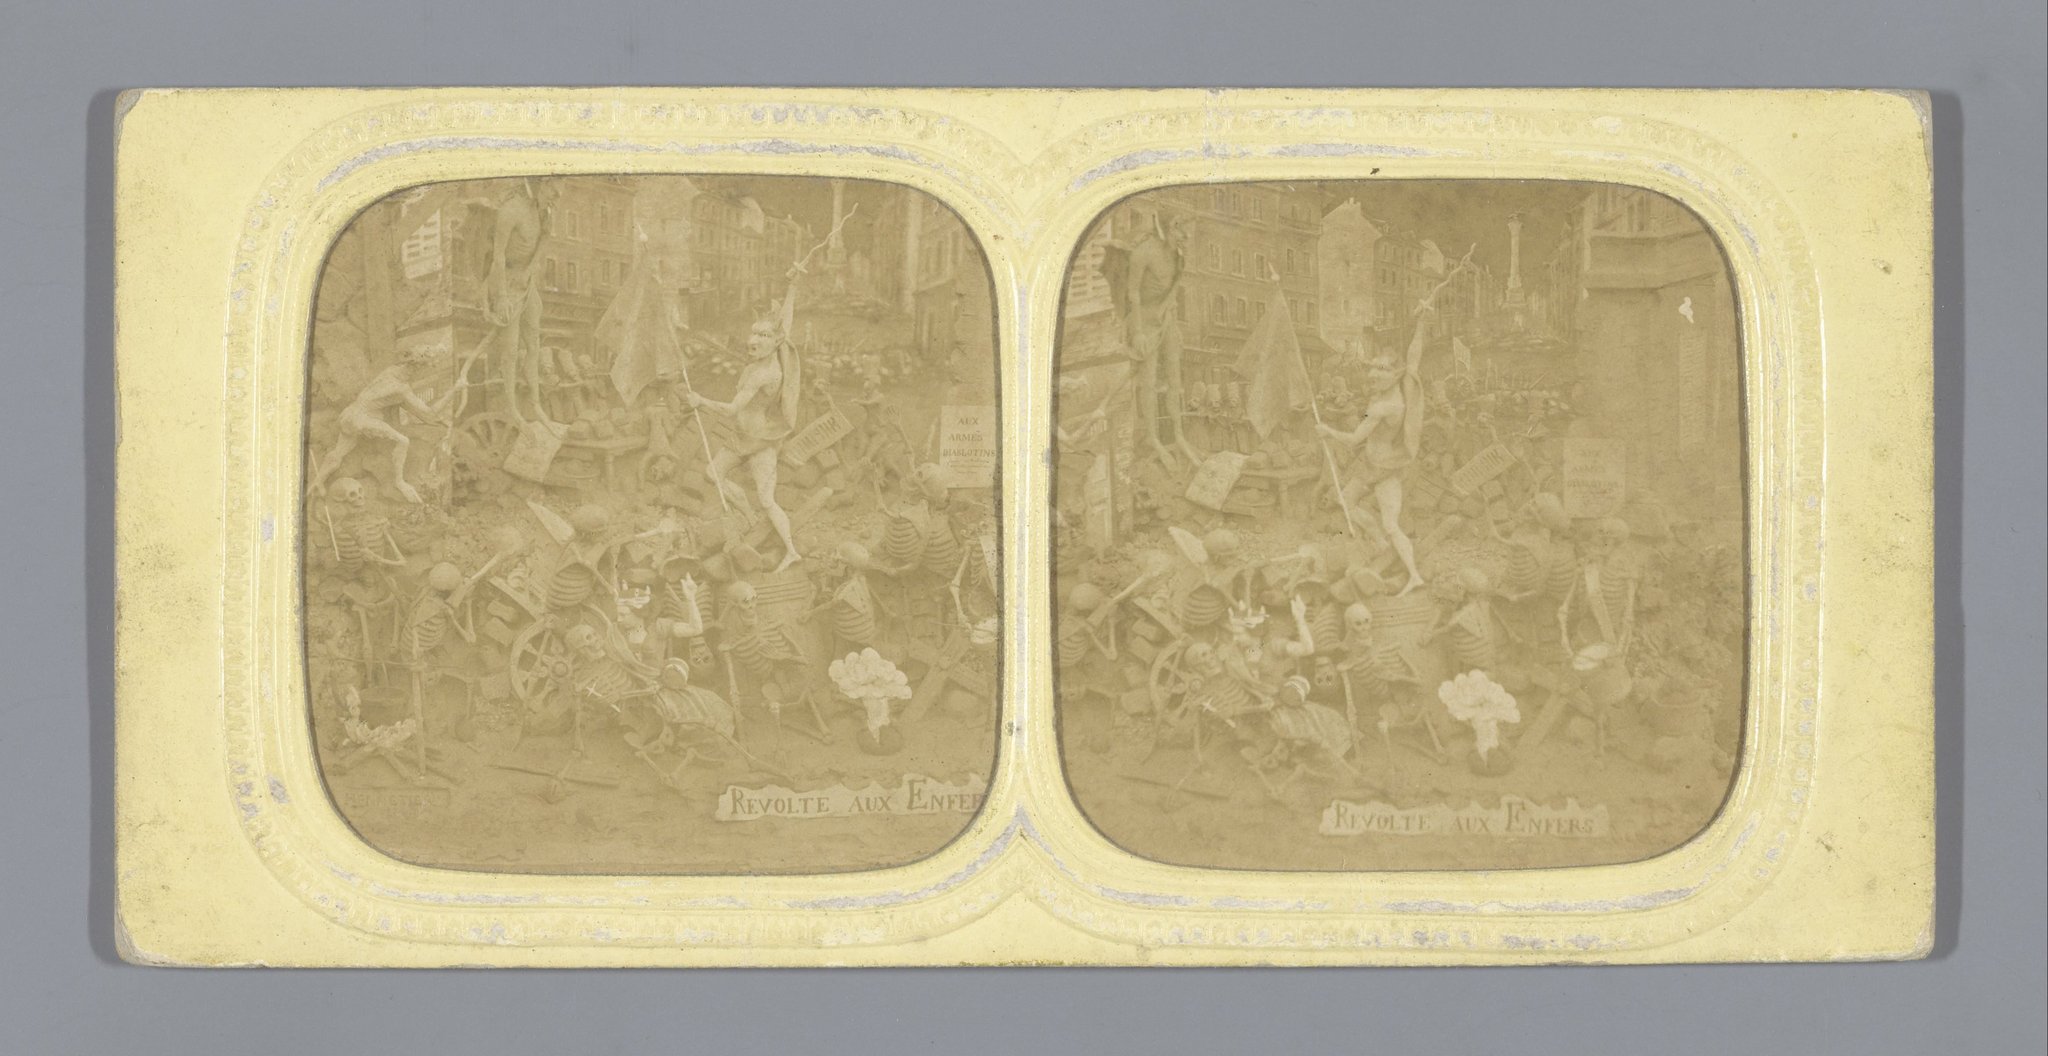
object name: tissue stereograph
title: Revolte aux Enfers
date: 1868-1873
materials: cardboard, paper, photographic support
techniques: albumen print, hand coloring, perforating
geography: paris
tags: devil(s) and demons, (human) skeleton, revolution, revolt, france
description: De serie 'Les Diableries' verbeeldt scènes van het dagelijkse leven in de hel, bedoeld als moralistisch en satirisch commentaar op het autoritaire bewind van Napoleon III in Frankrijk. De taferelen werden minutieus uit klei gefabriceerd en vervolgens met een stereocamera gefotografeerd.